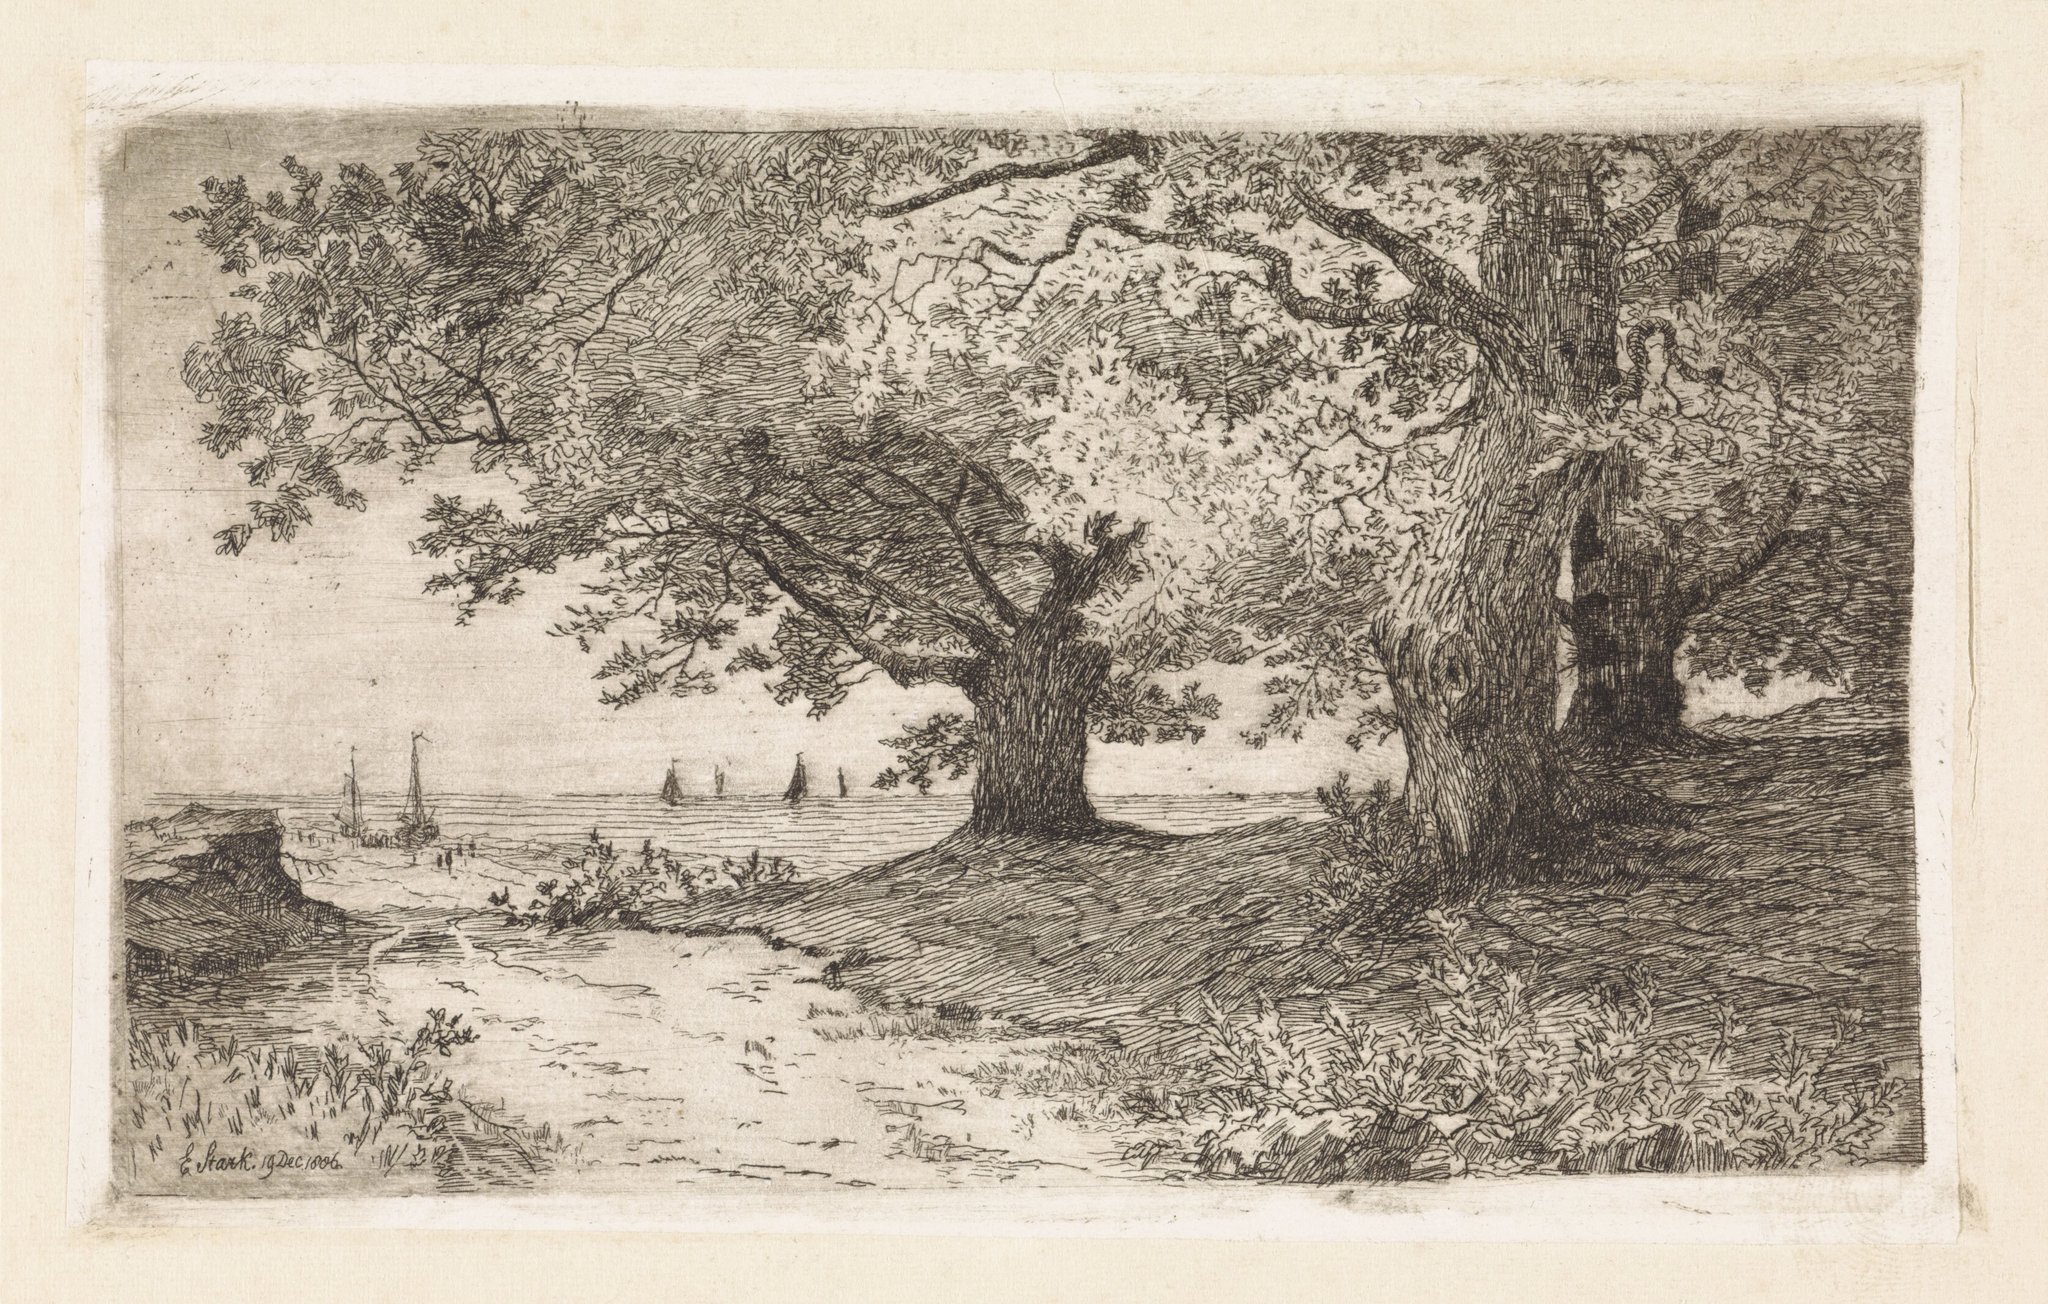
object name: print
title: Landschap met bomen, strand en zee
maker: elias stark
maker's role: draughtsman, print maker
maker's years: 1849-1933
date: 1886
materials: paper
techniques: etching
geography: nieuwer-amstel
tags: trees, sailing-ship, sailing-boat, sea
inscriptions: collector's mark: Lugt 2228